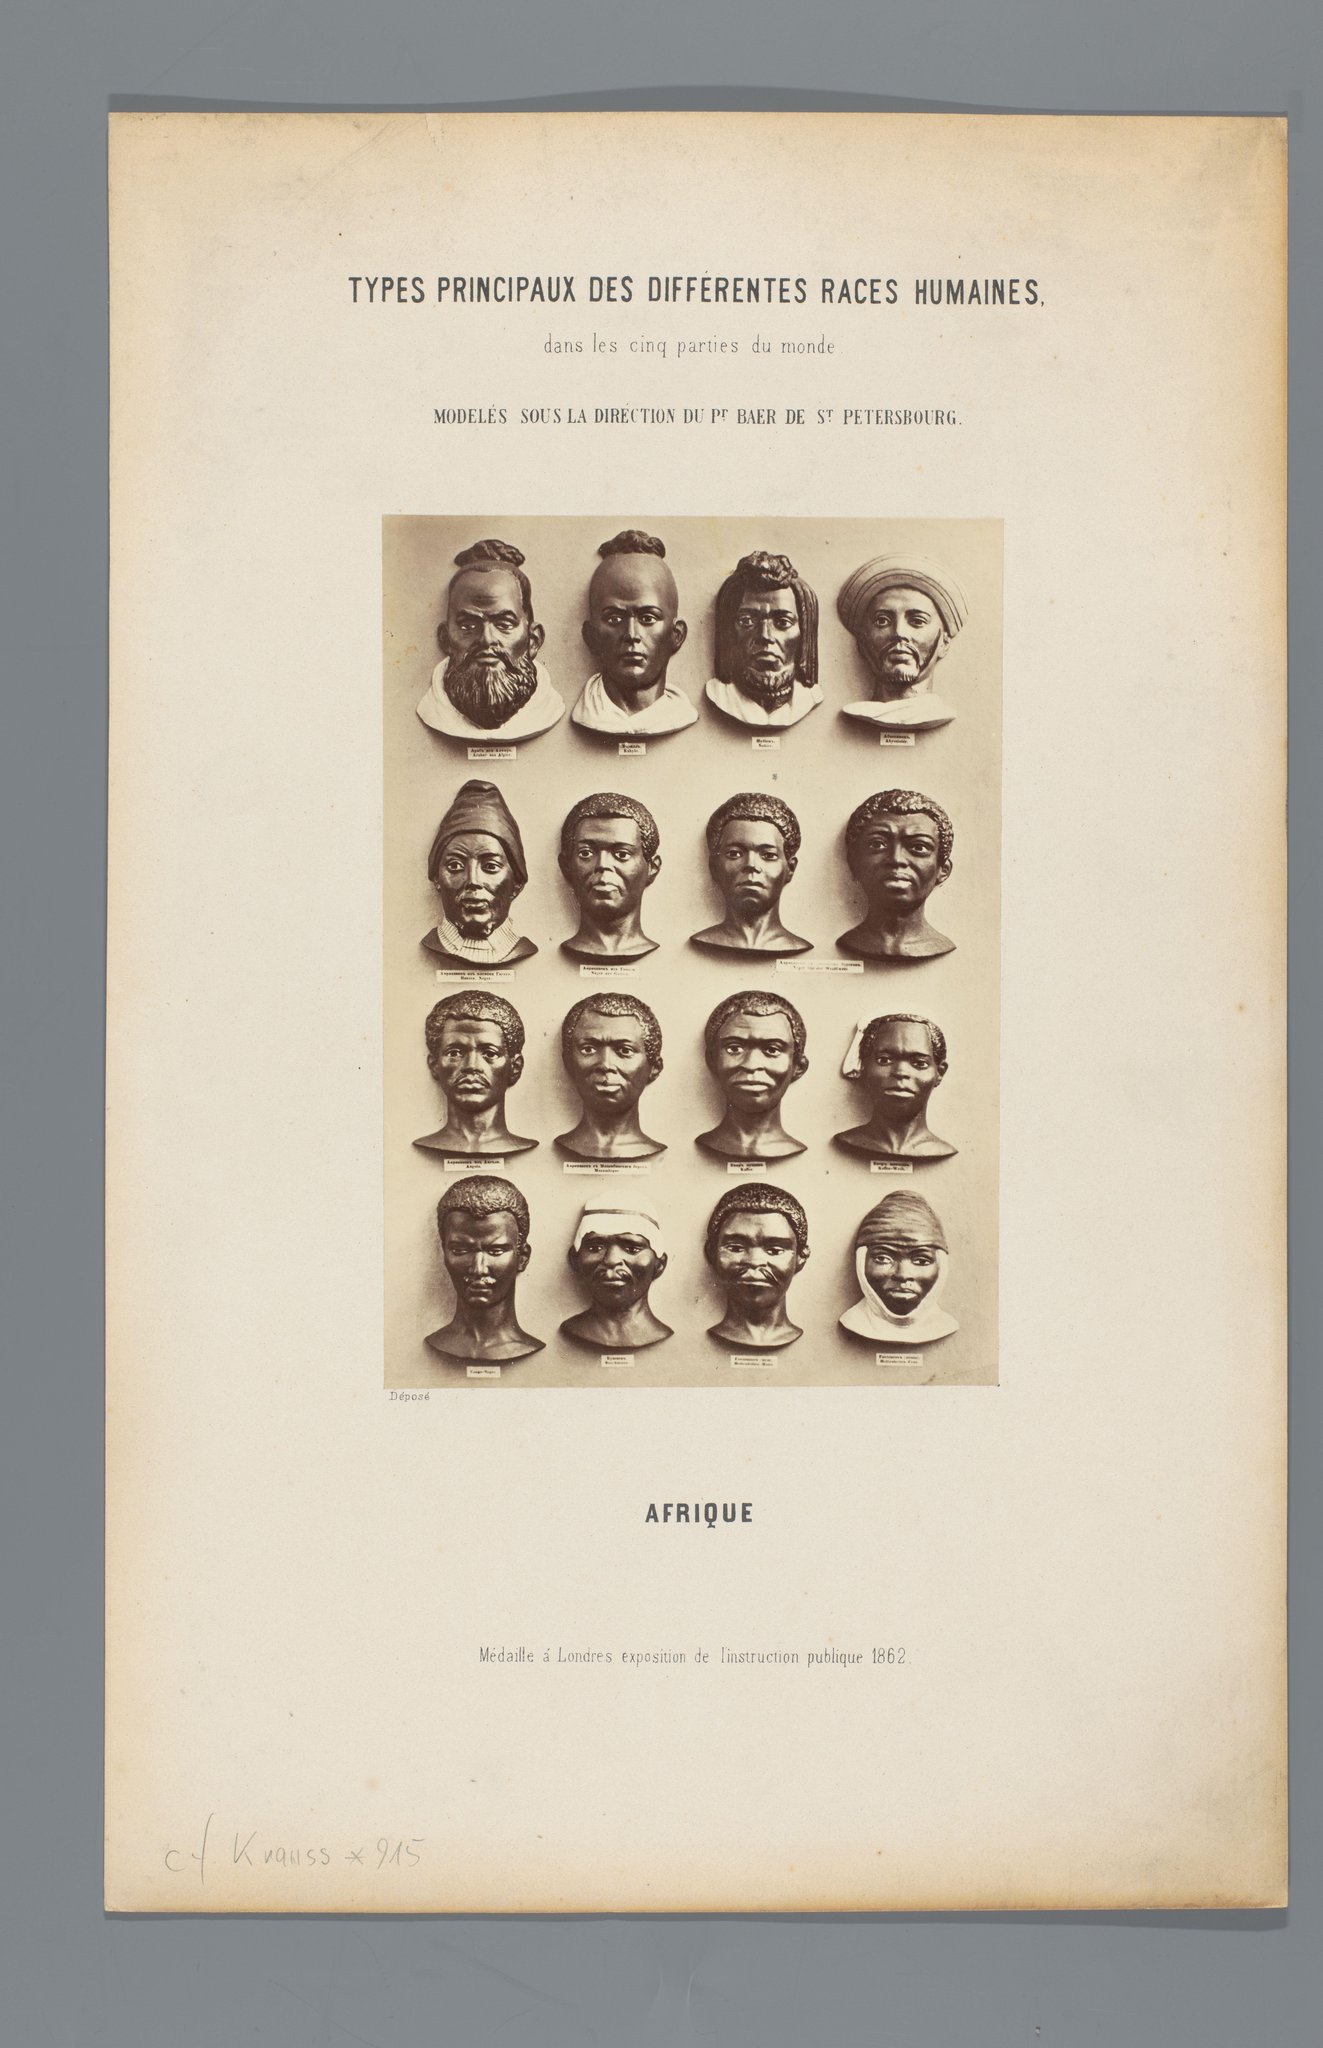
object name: photograph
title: Zestien beeldjes van hoofden van bewoners van Afrika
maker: Anonymous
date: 1857-1862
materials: paper, photographic support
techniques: albumen print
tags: africans, piece of sculpture, reproduction of a piece of sculpture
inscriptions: inscription: ‘TYPES PRINCIPAUX DES DIFFÉRENTES RACES HUMAINES./ dans les cinq parties du monde/ MODELÉS SOUS LA DIRÉCTION DU Pr BAER DE St PETERSBOURG.’, annotation: ‘cf. Kra[.]ss *915’, inscription: ‘Déposé’, inscription: ‘Médaille á Londres exposition de l'instruction publique 1862.’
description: Deze foto maakt deel uit van een omslag met vijf foto's.